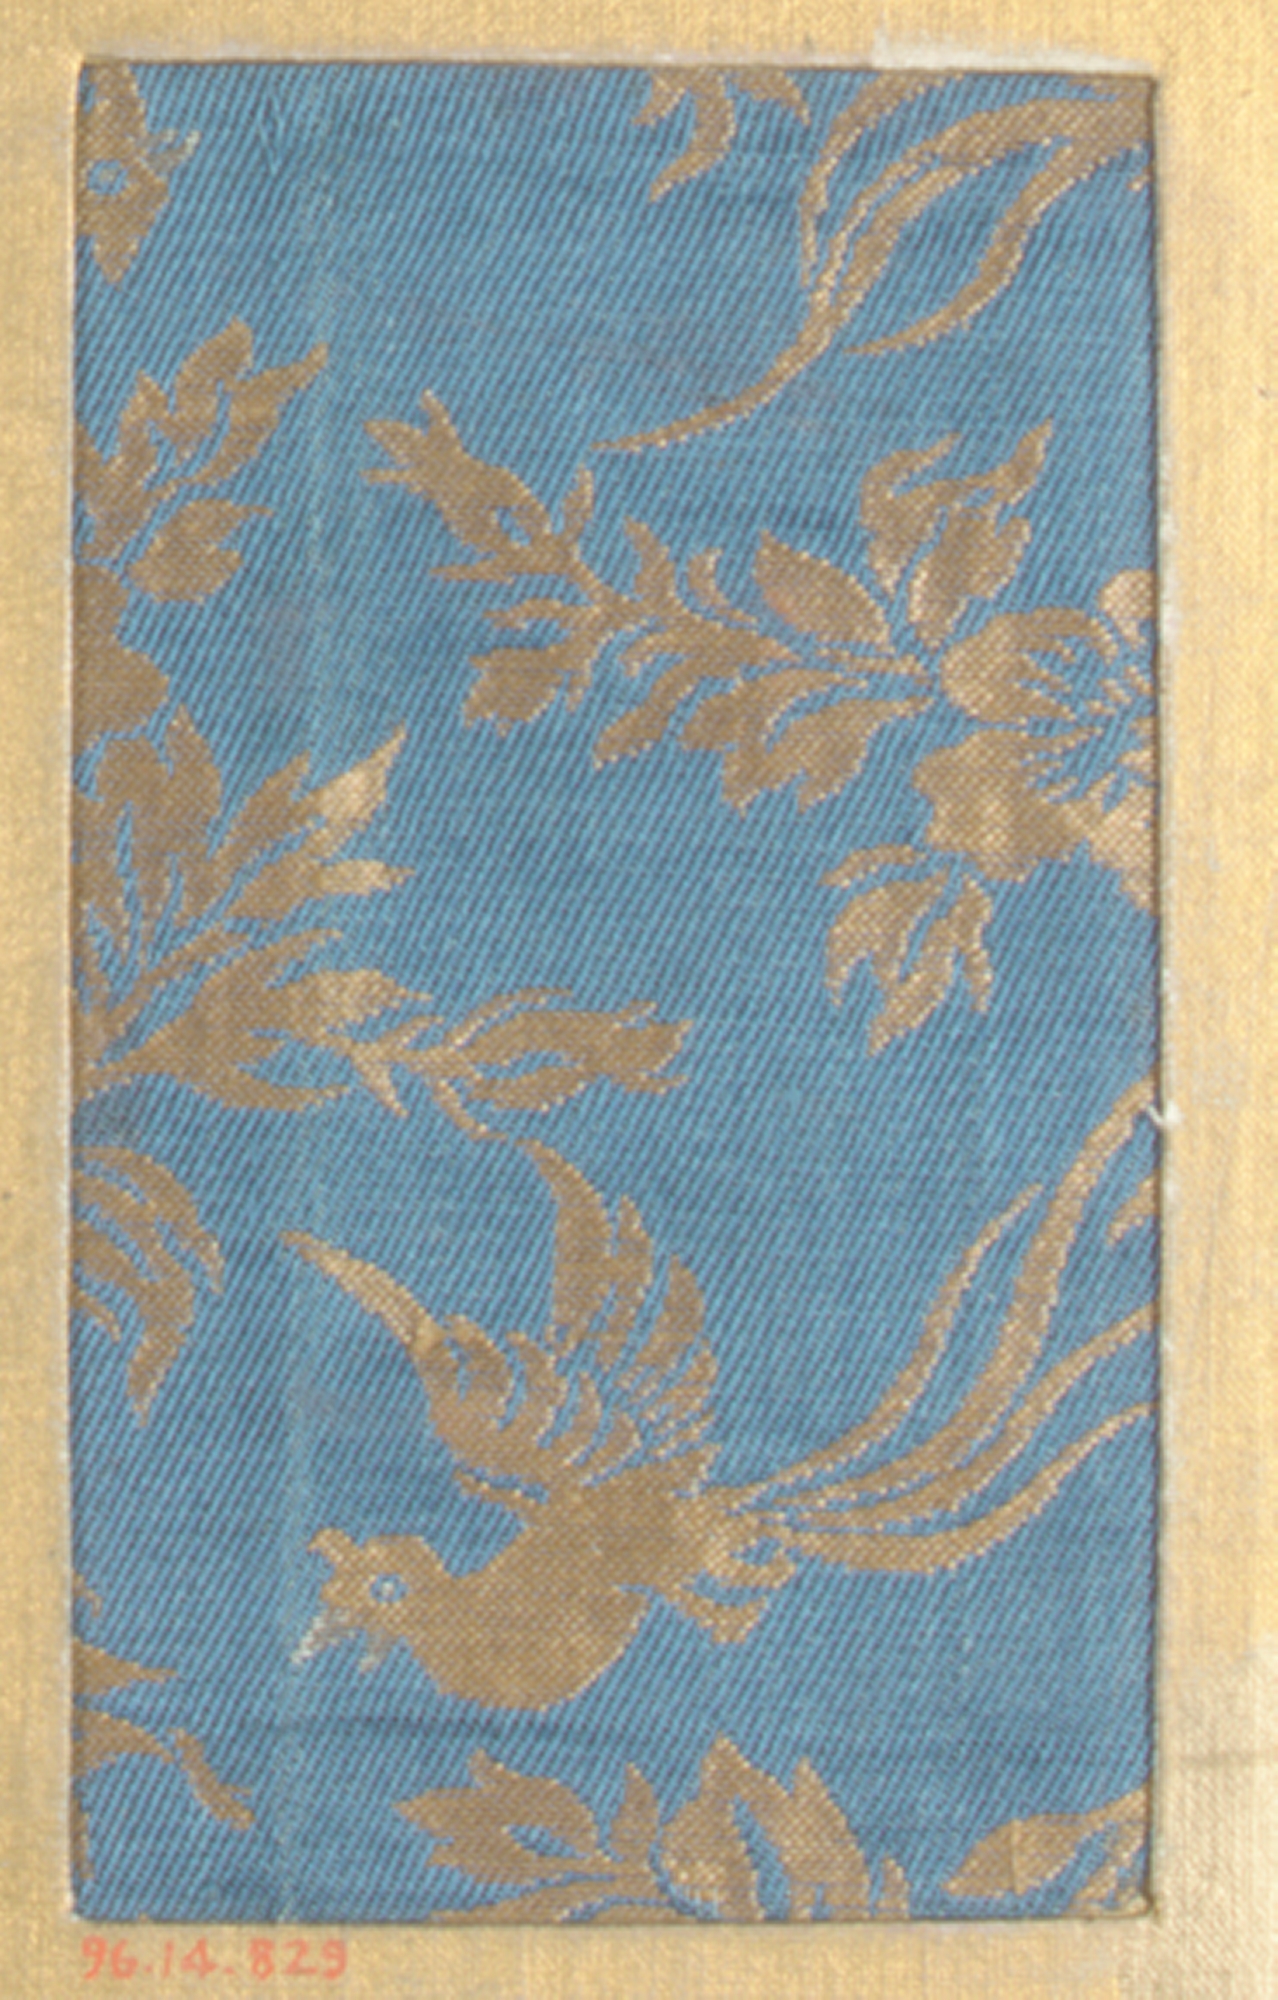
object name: piece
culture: japanese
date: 1701-1900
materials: silk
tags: birds